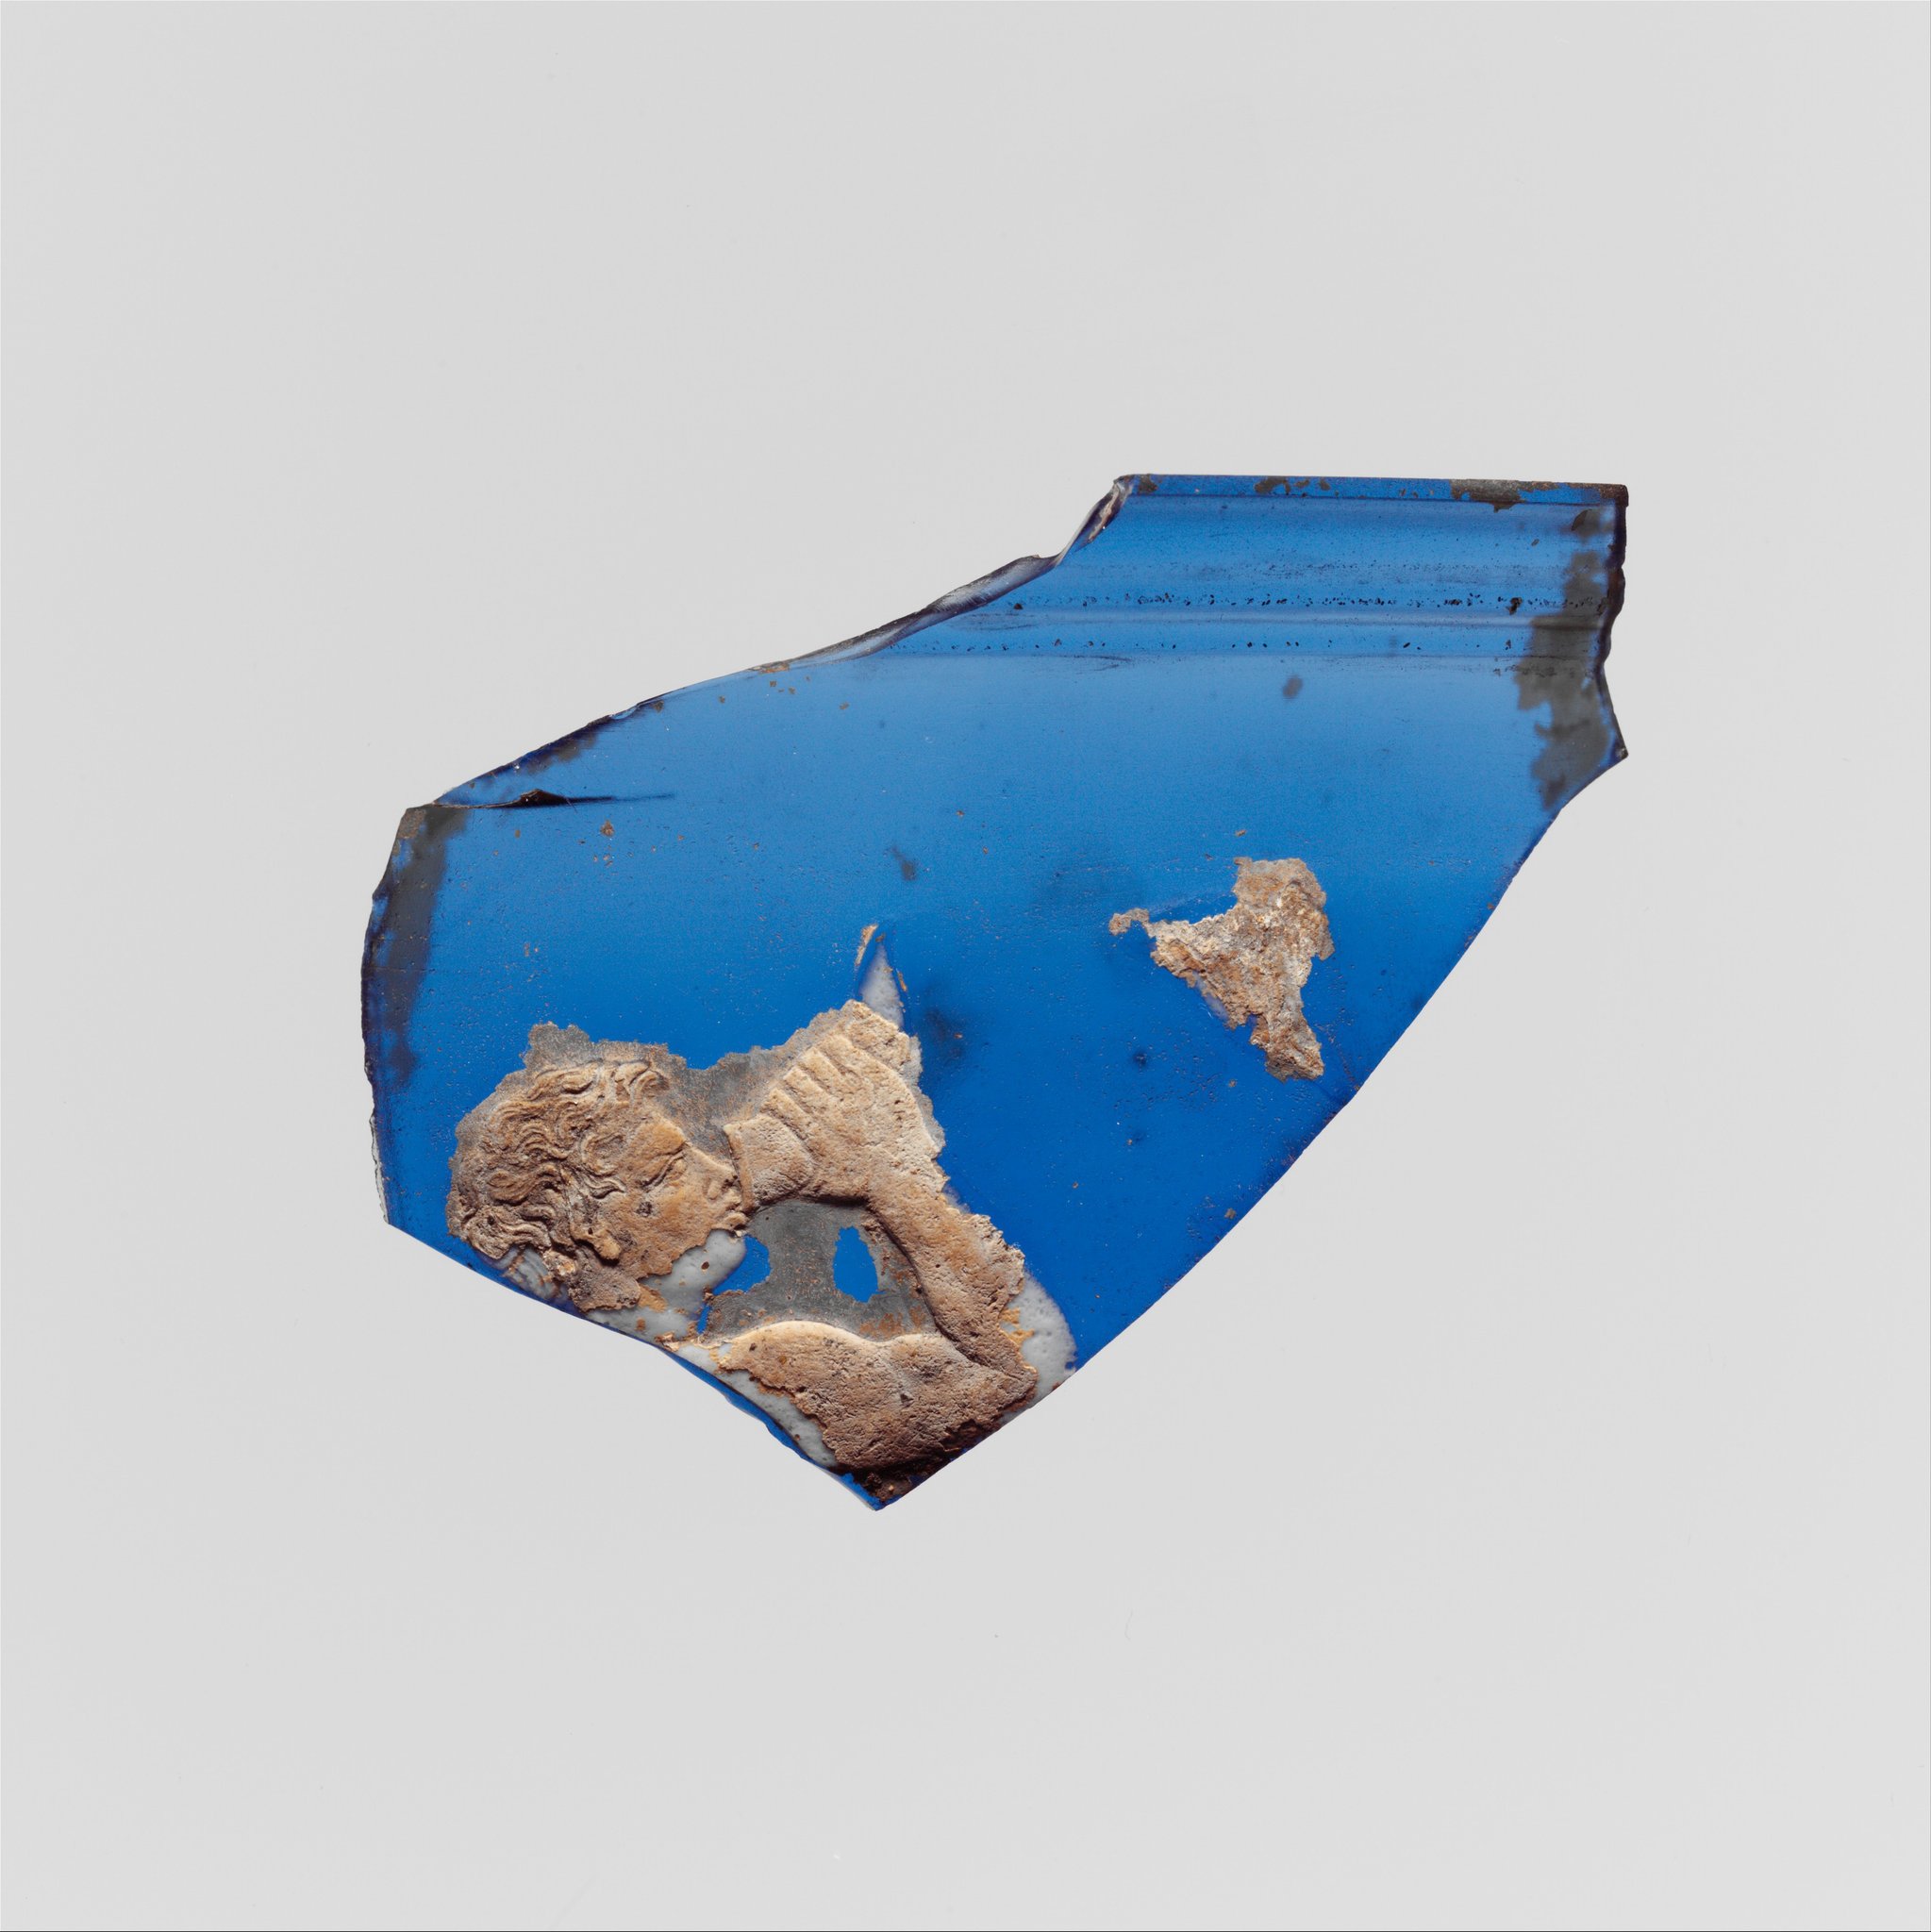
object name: cameo, bowl fragment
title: Glass cameo bowl fragment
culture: roman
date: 67-100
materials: glass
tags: satyrs,drinking